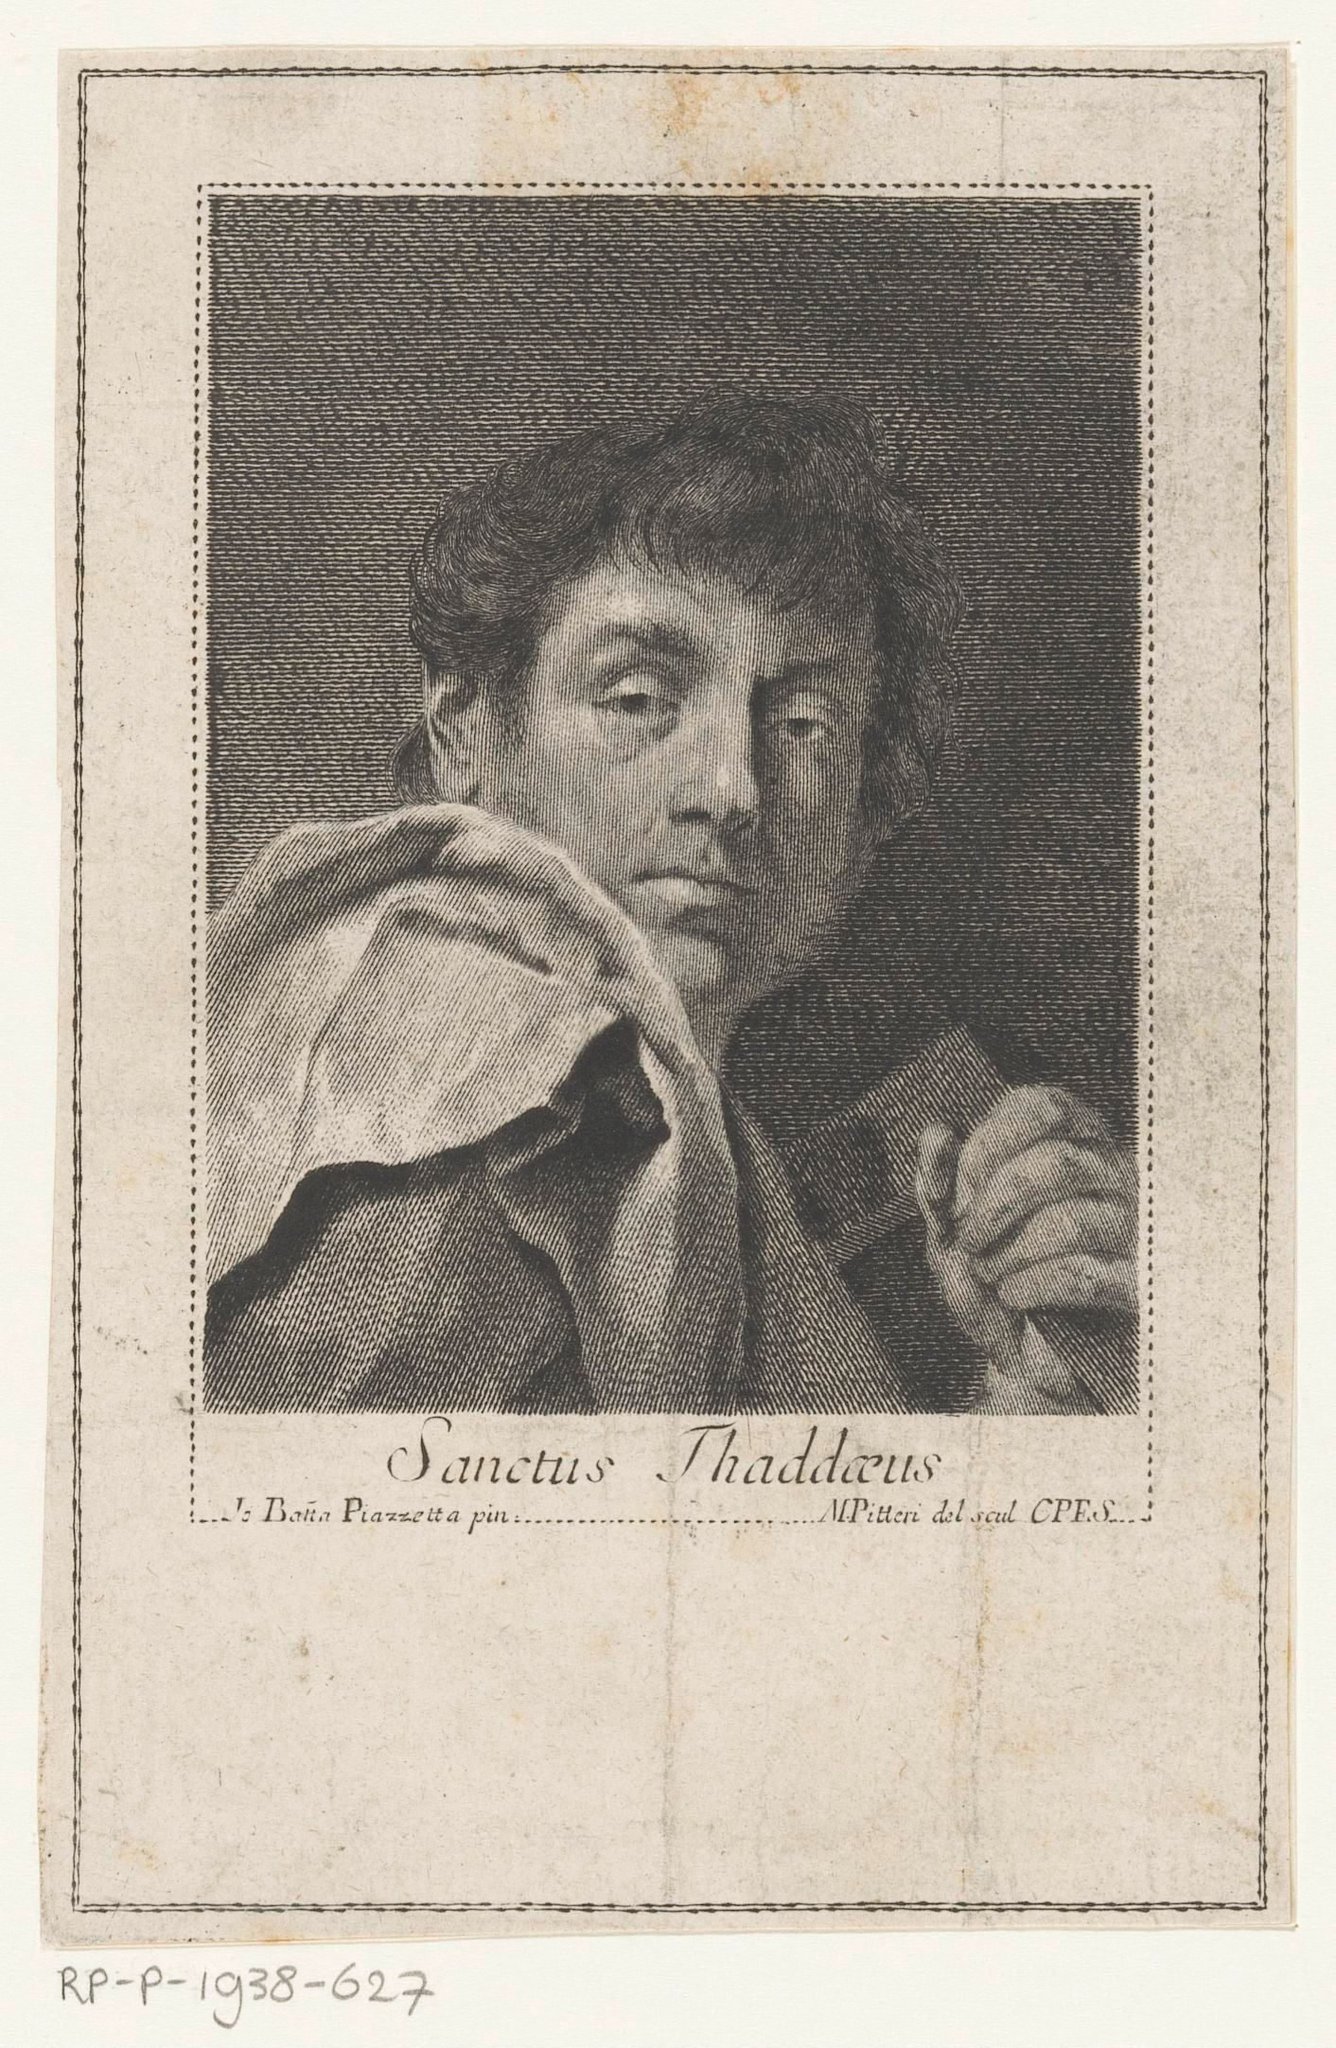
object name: print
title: Apostelen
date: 1712-1786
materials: paper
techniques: engraving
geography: venice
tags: the apostle jude thaddaeus; possible attributes: book, club, halberd, scroll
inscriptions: collector's mark: Lugt 2760, collector's mark: Lugt 2228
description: Deze prent maakt deel uit van een reeks van 12 prenten.